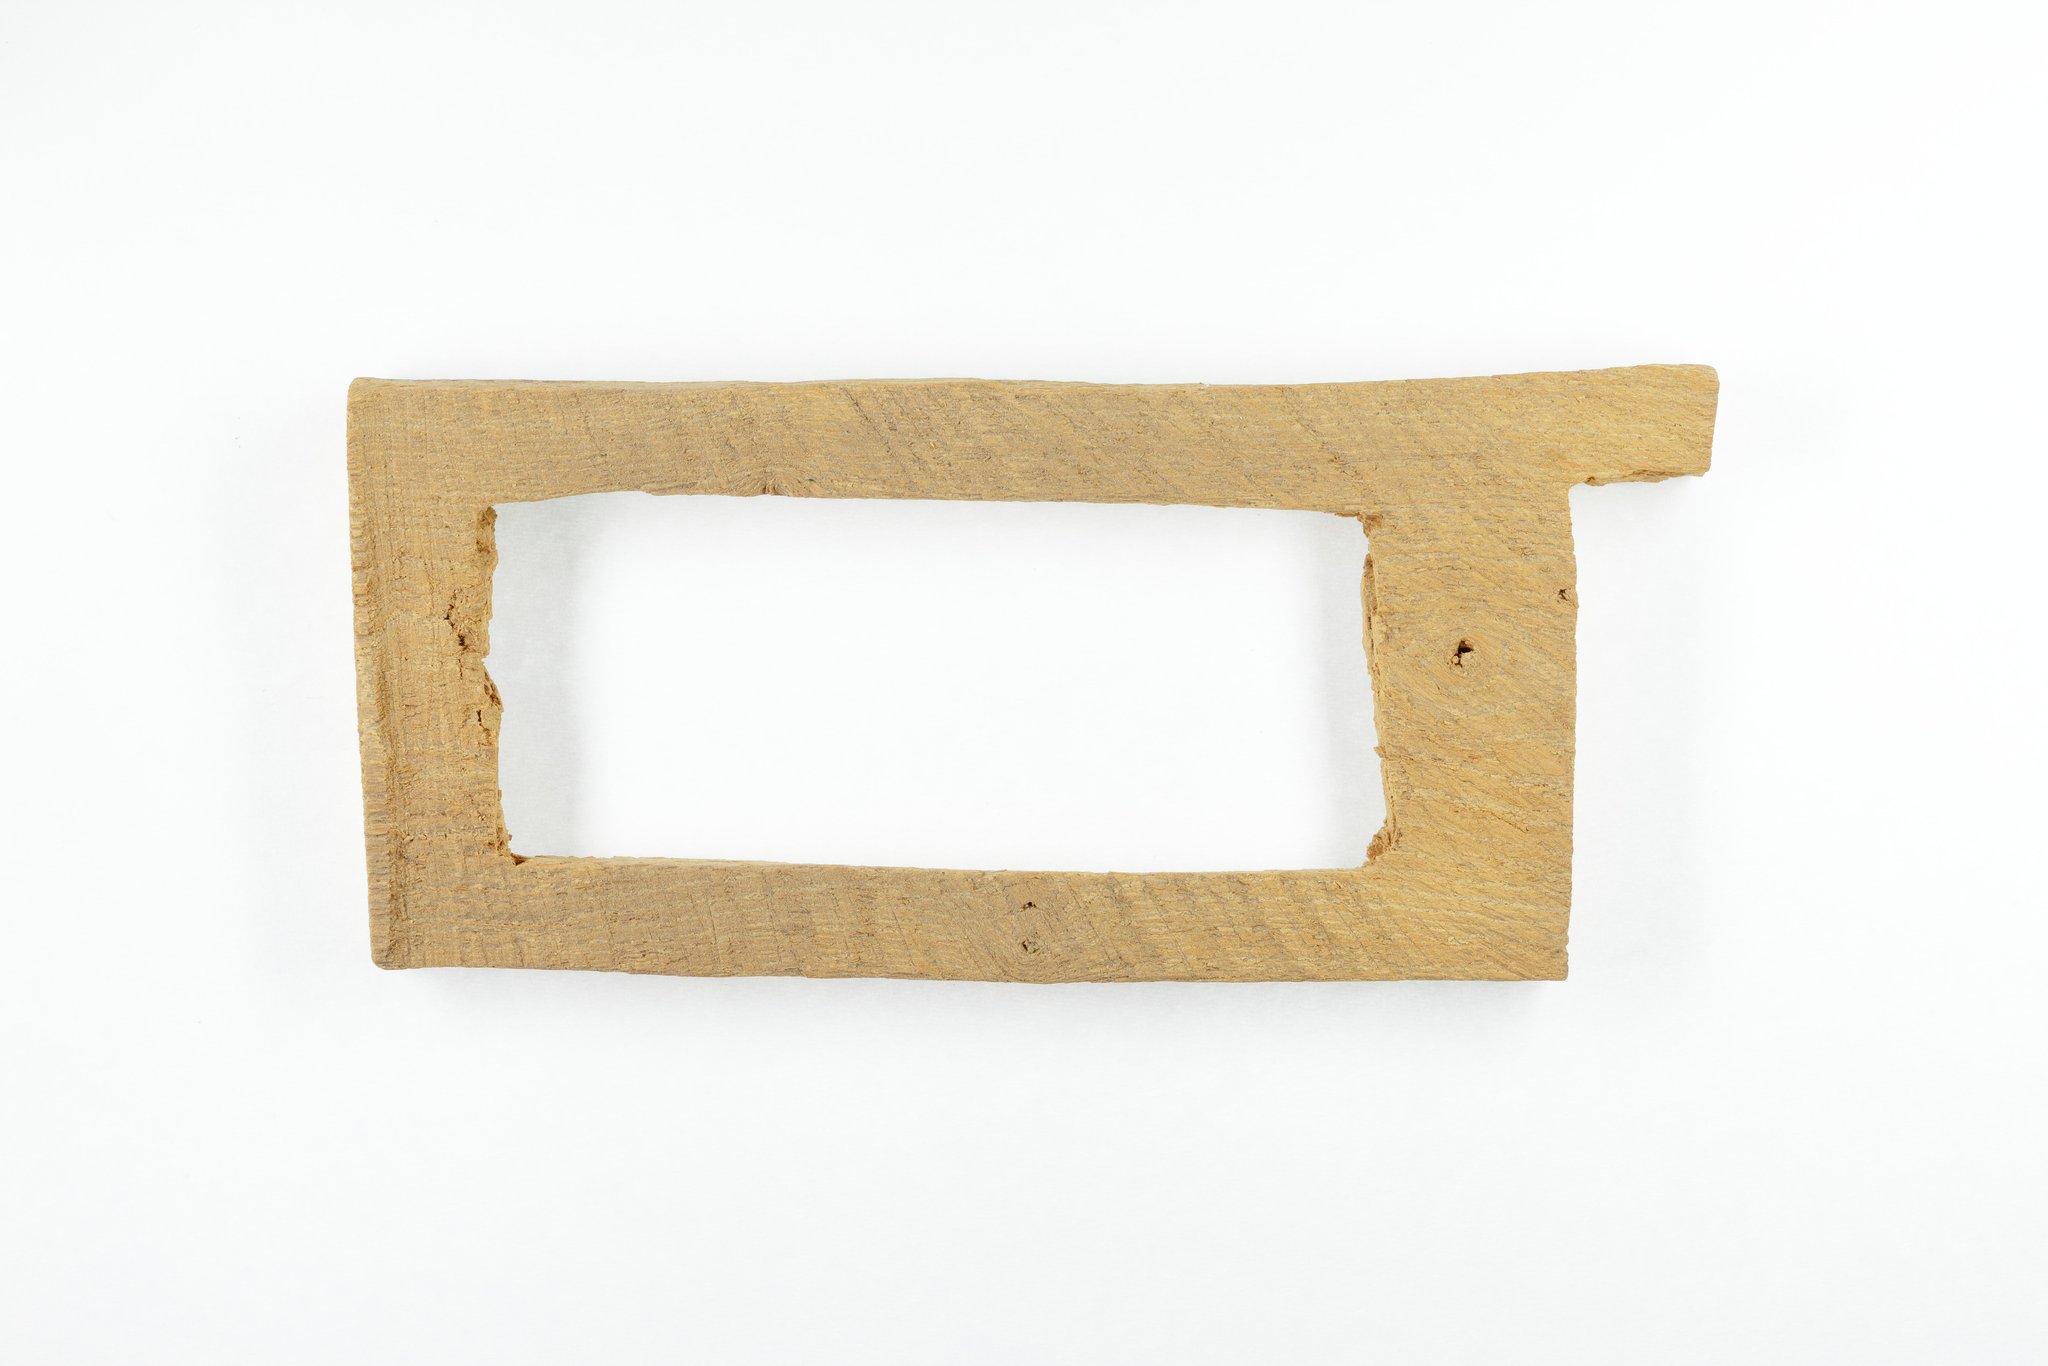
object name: brick mold, model, tool, senenmut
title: Model Brick Mold from a Foundation Deposit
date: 1479-1458 BCE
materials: wood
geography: egypt